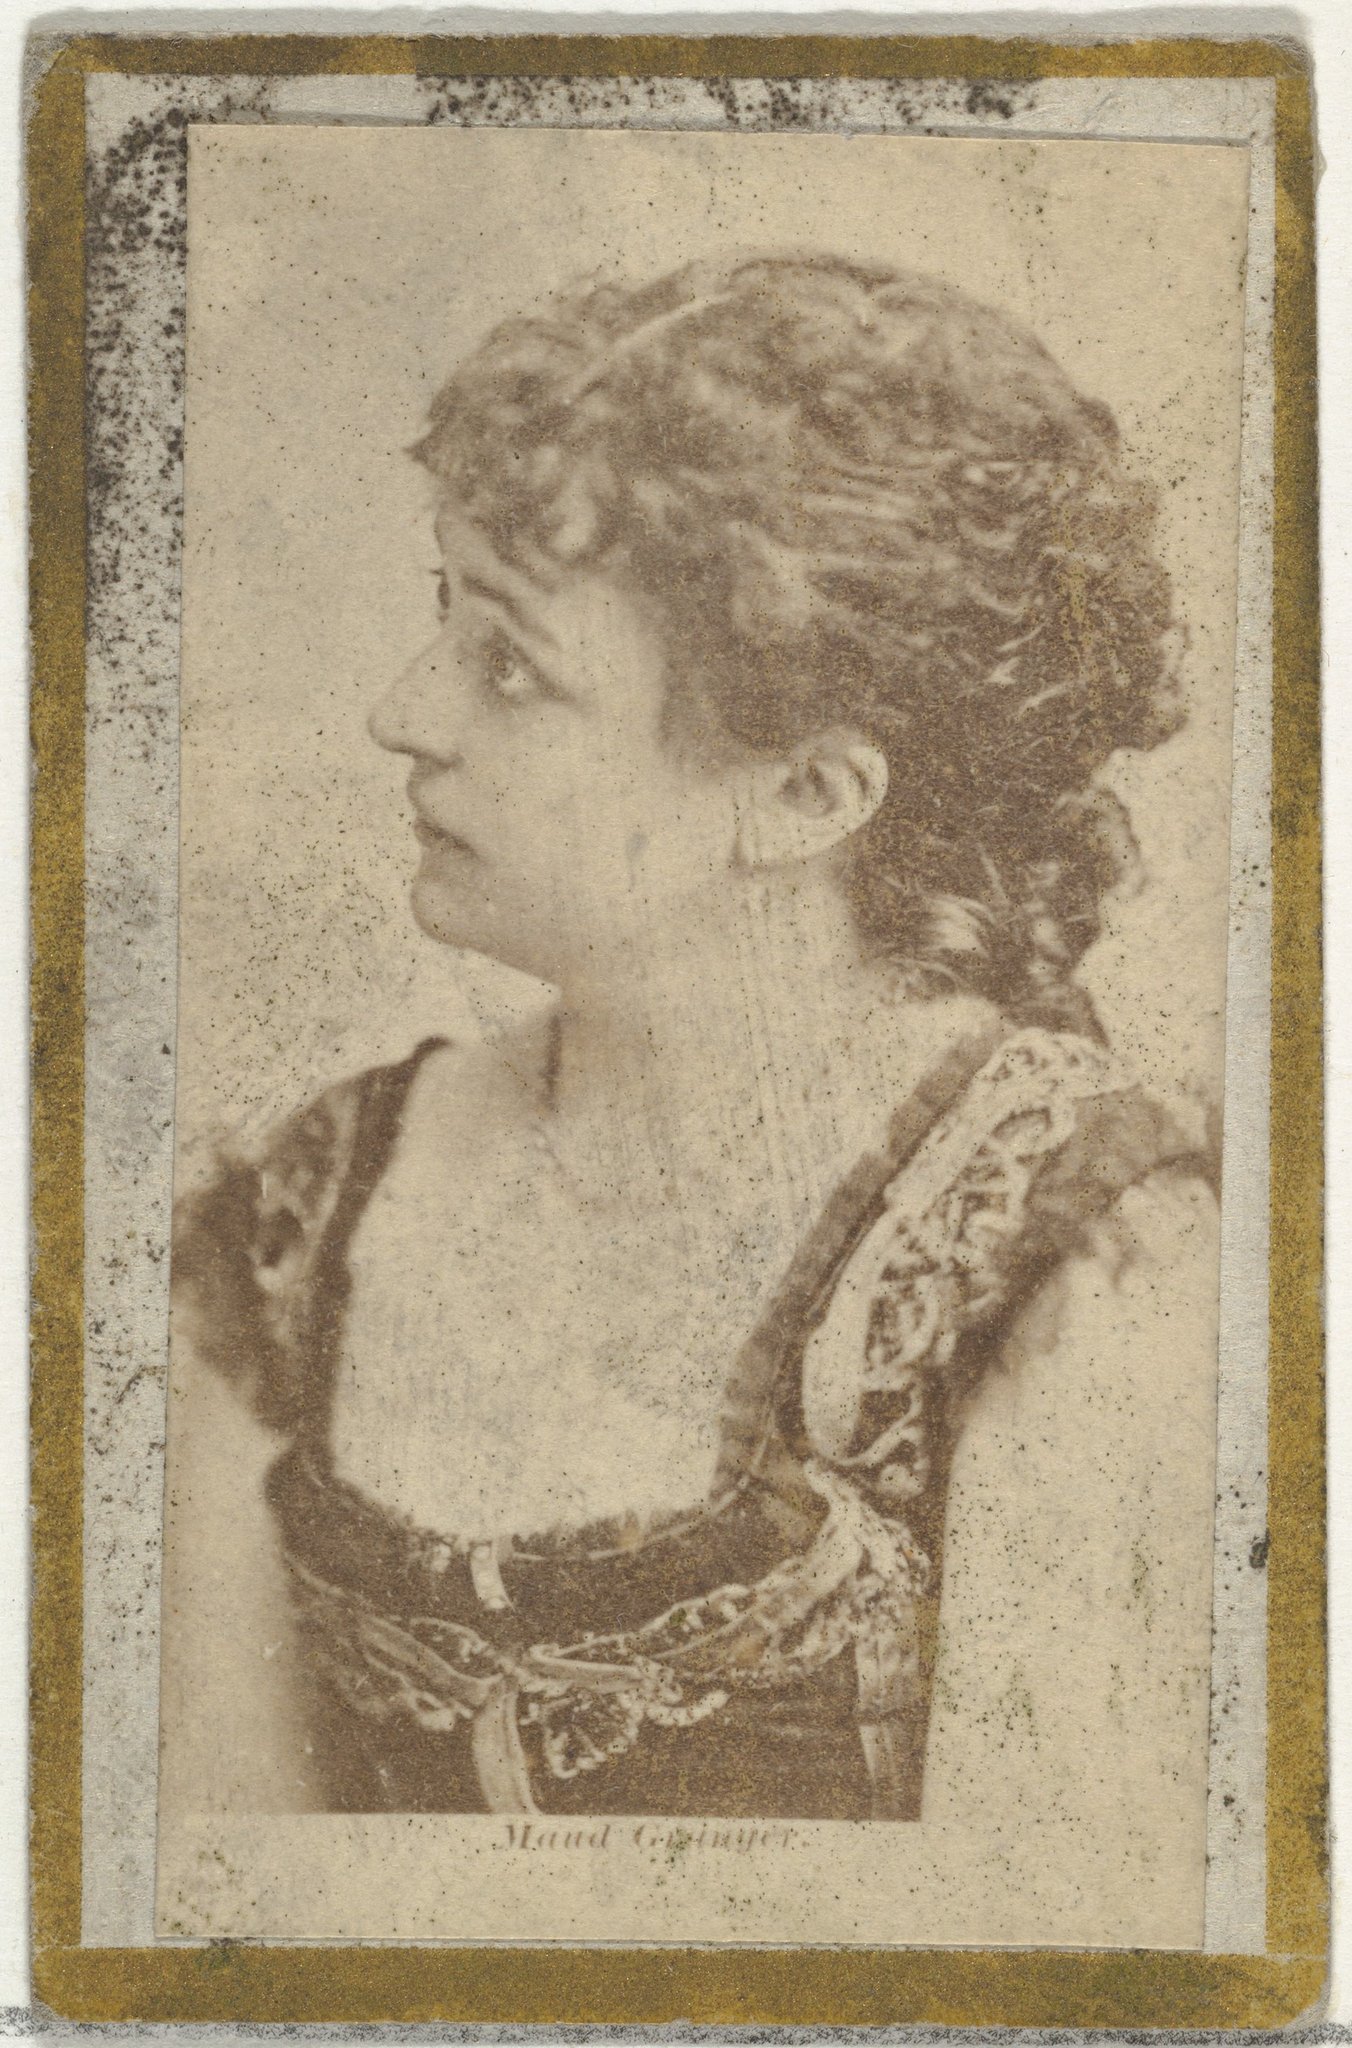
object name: photograph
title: Maud, from the Actresses and Celebrities series (N60, Type 2) promoting Little Beauties Cigarettes for Allen & Ginter brand tobacco products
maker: allen & ginter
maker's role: publisher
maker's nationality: american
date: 1887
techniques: albumen silver print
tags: portraits,profiles,women,actresses